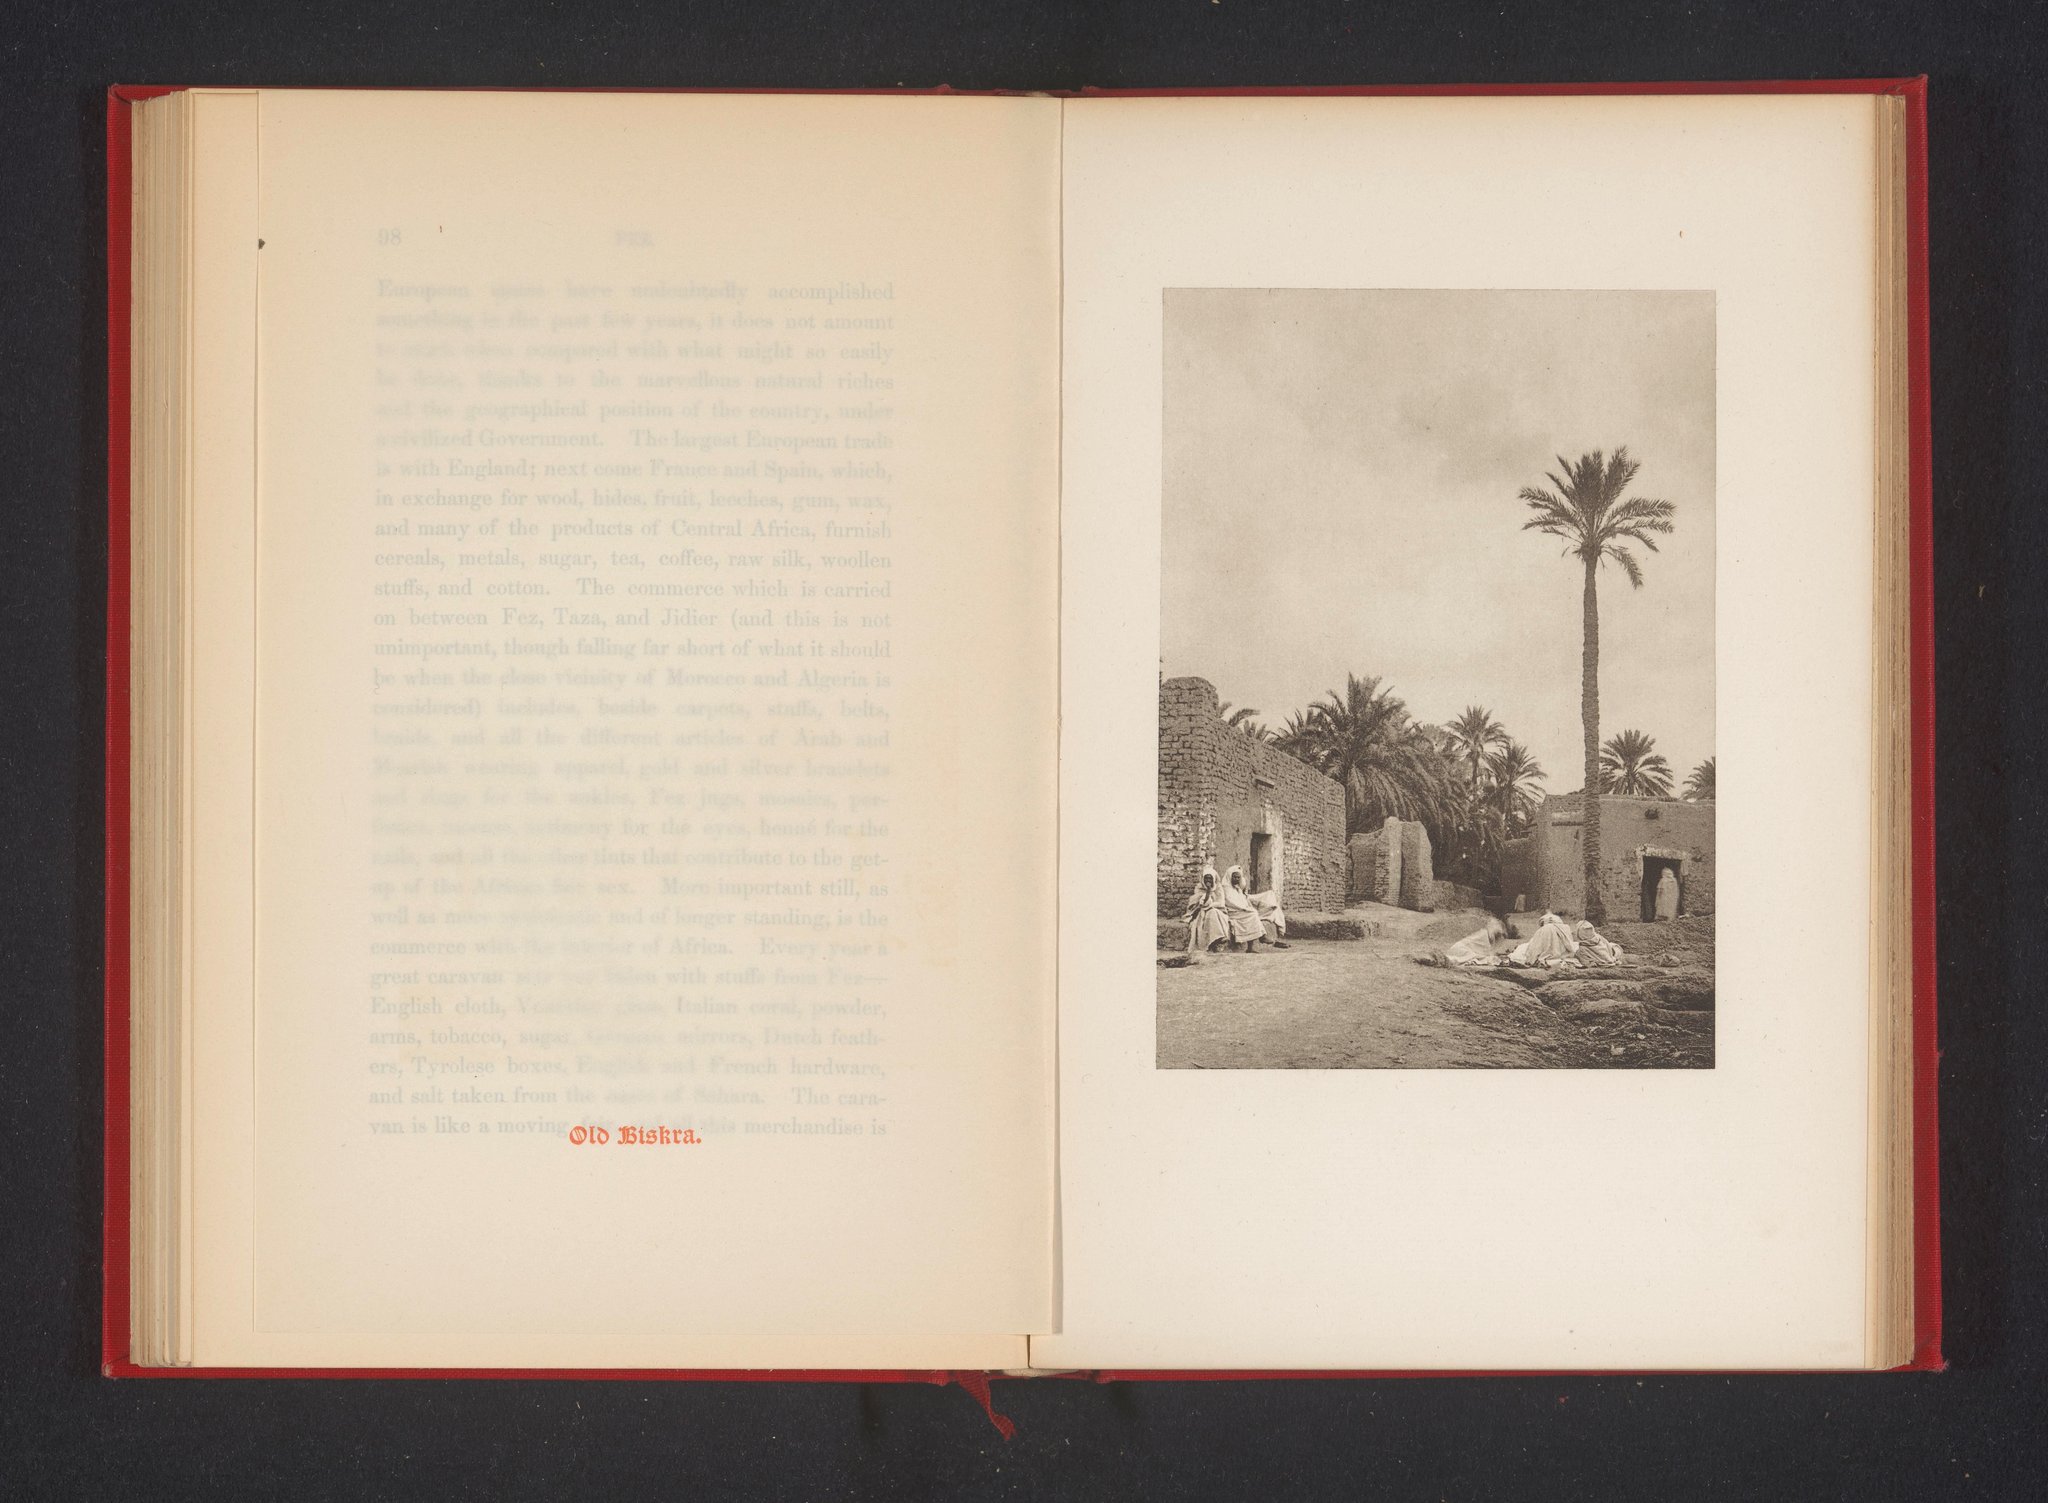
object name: page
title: Woningen te Biskra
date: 1887-1897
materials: paper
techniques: photoaquatint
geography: biskra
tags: housing, façade (of house or building)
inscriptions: title: ‘Old Biskra.’